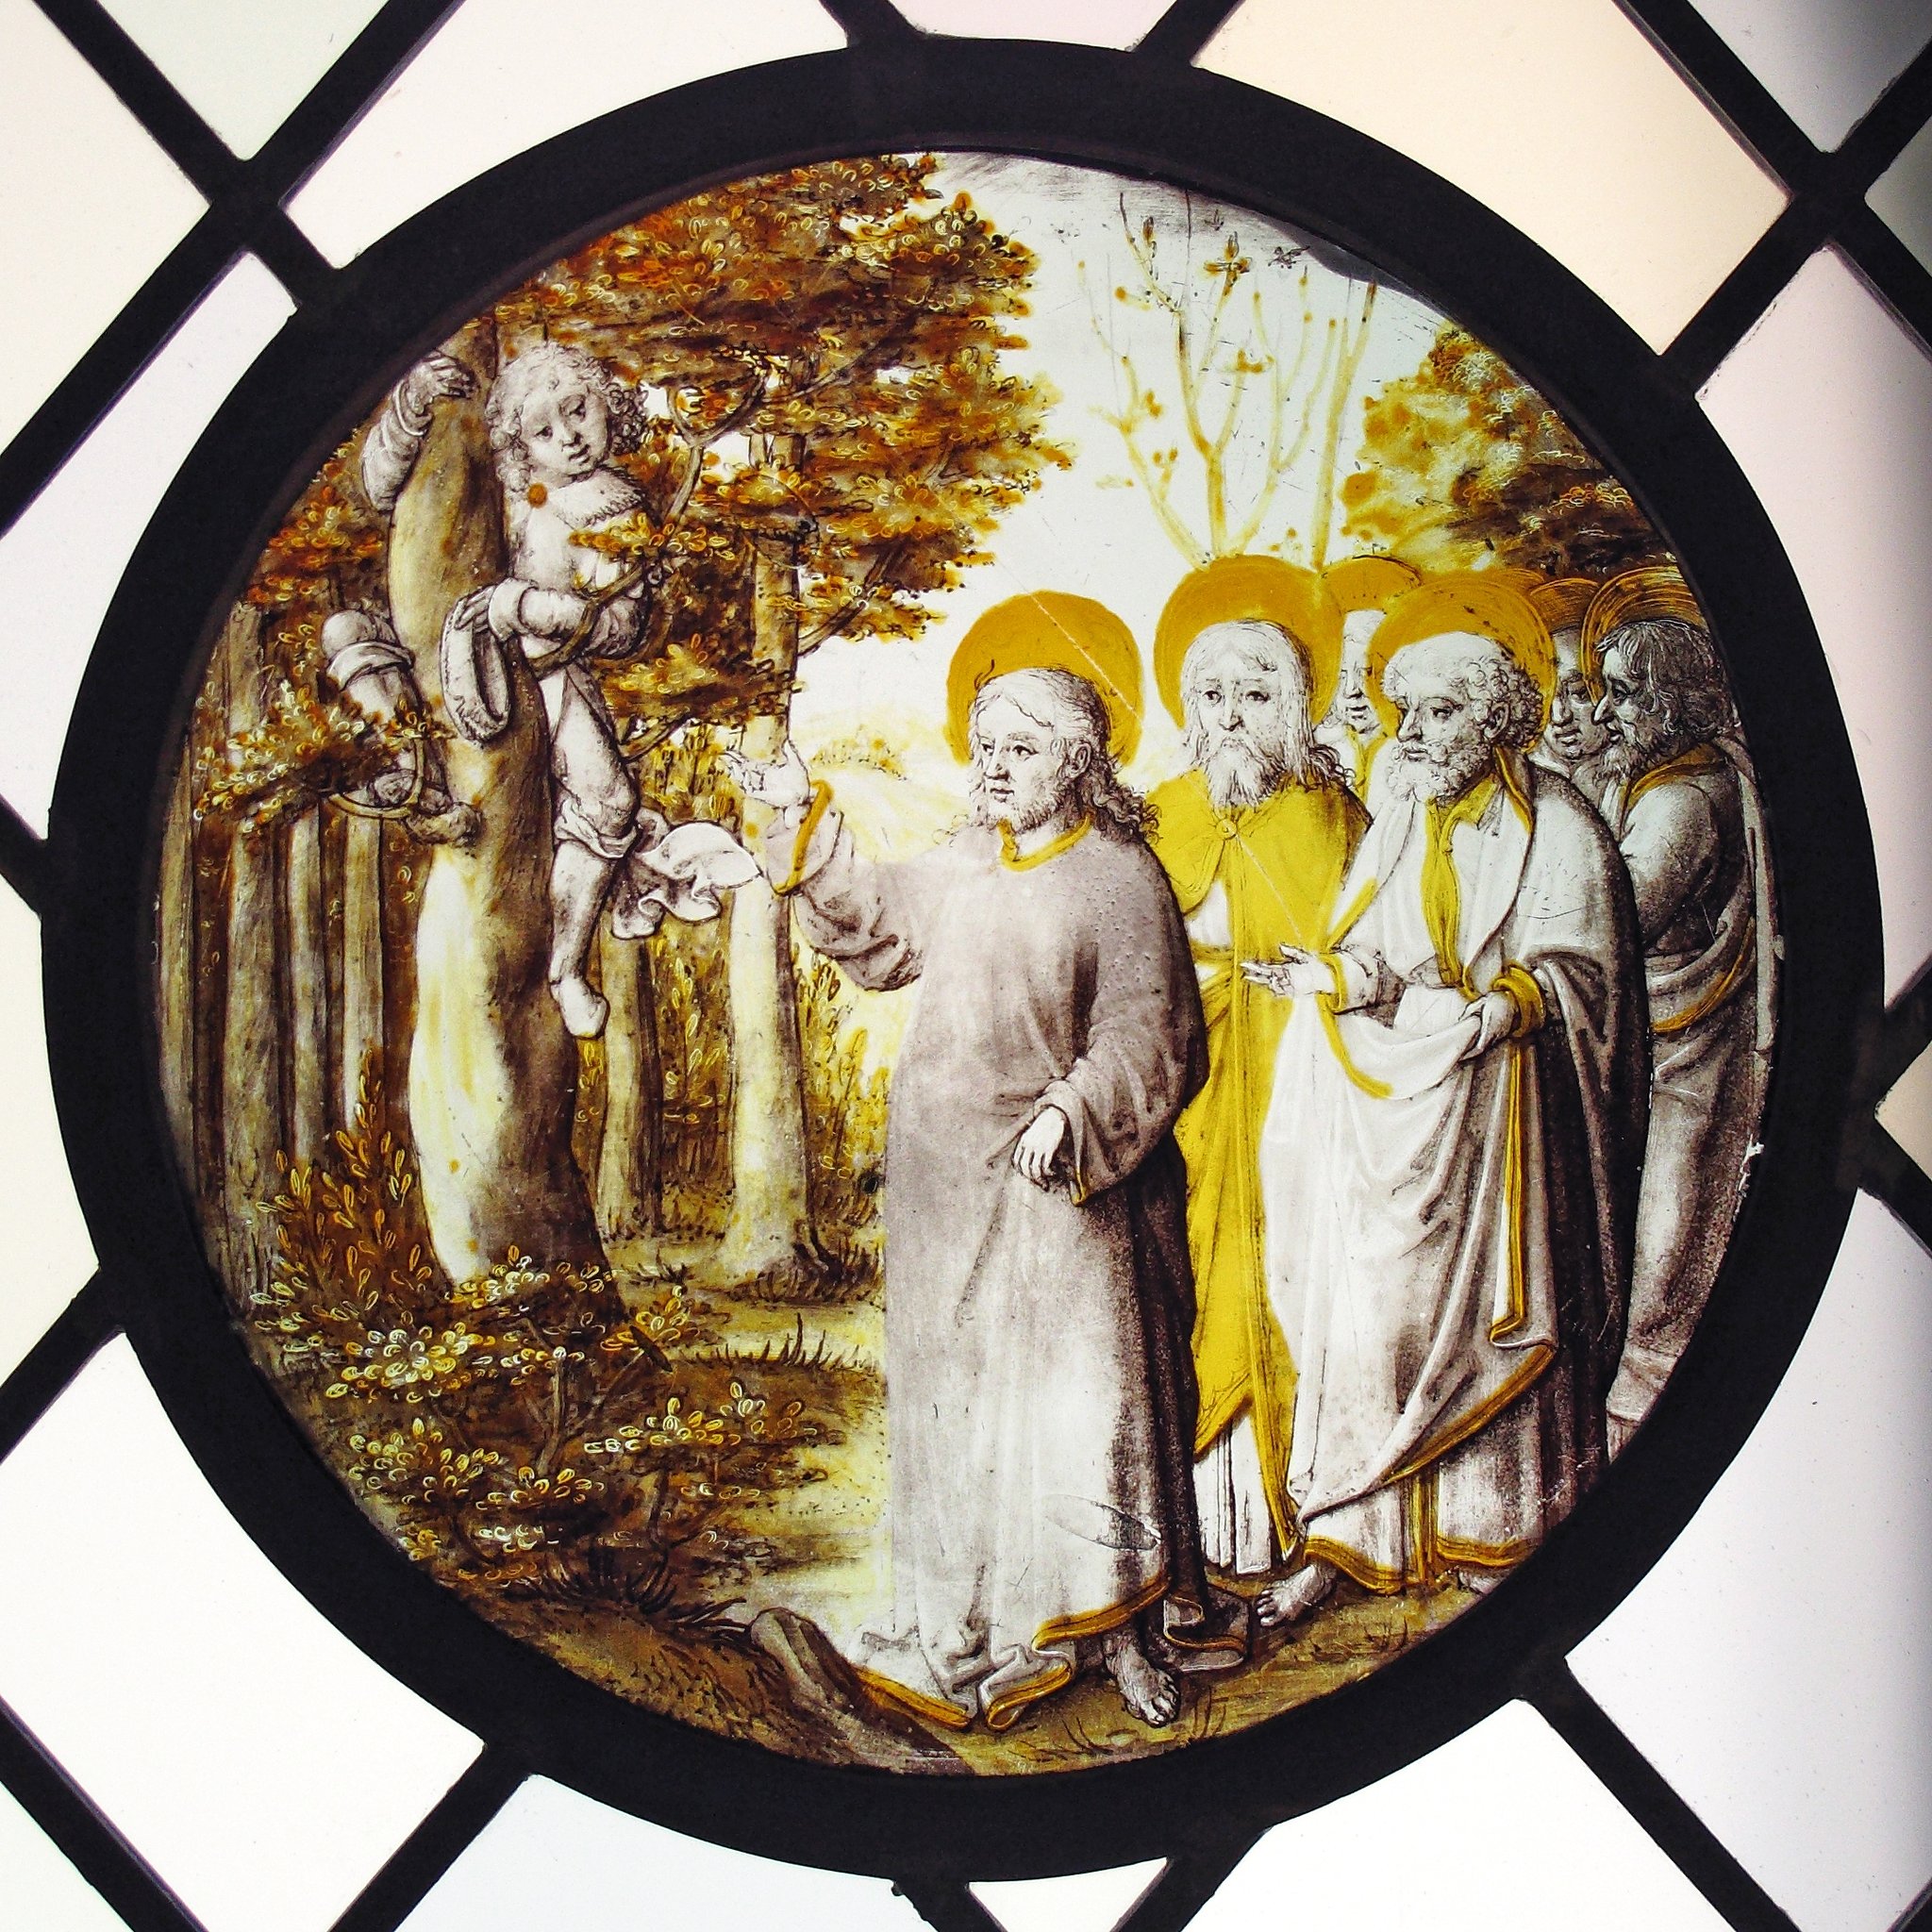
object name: roundel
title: Roundel with Christ and Zacchaeus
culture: dutch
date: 1500-1510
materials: glass, paint, pigment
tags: men,christ